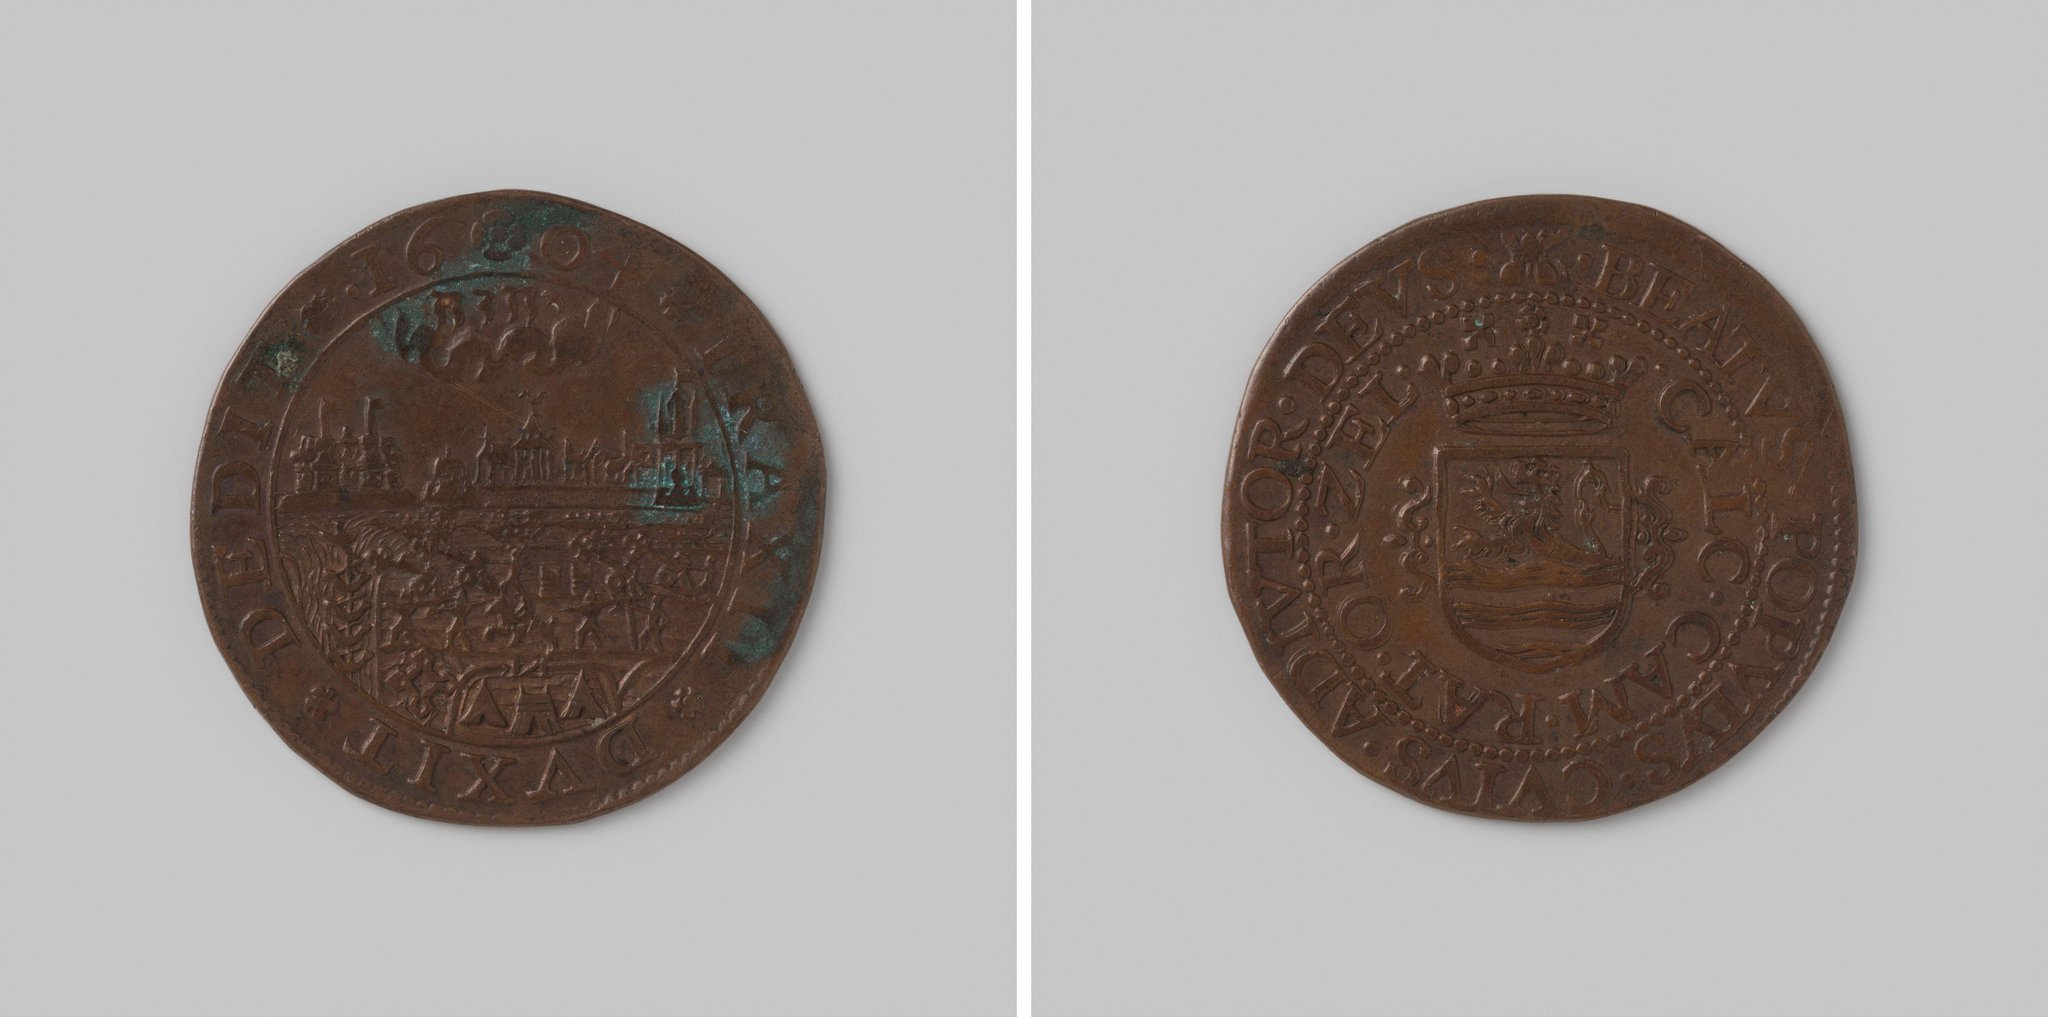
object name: jeton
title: Rekenpenning uit Middelburg voor de Rekenkamer van Zeeland op de inname van Sluis 1604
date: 1604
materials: copper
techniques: striking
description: Koperen penning, op de voorzijde het aanzicht van de belegerde stad,met omschrift, op de keerzijde het gekroonde wapenschild van Zeeland met dubbel omschrift, gescheiden door een parelcirkel.